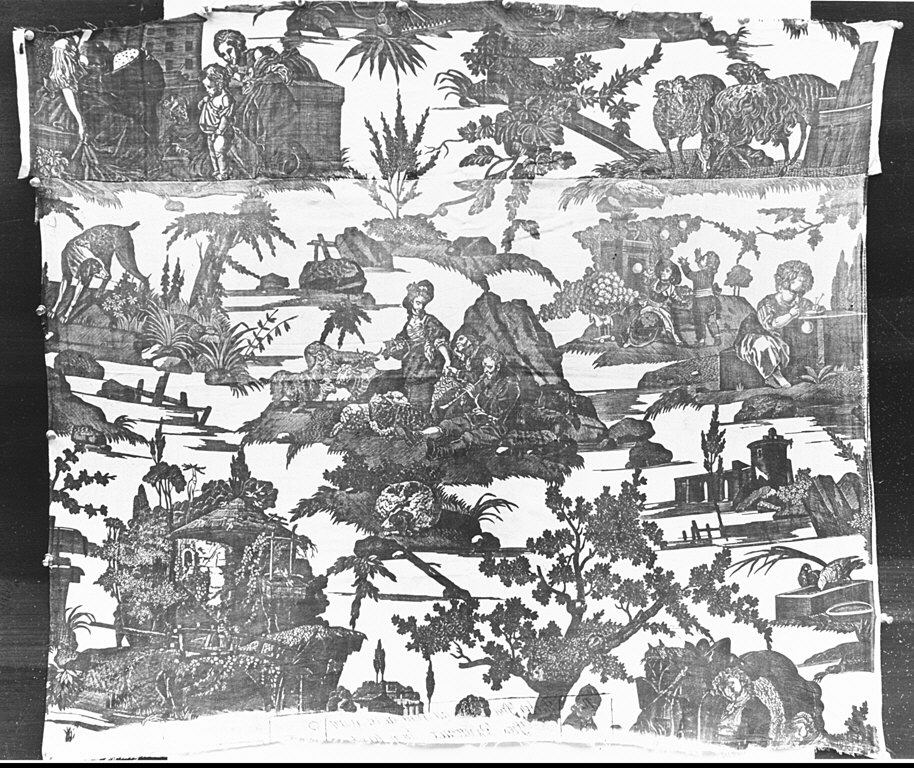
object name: piece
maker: lecler, père et fils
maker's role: manufactory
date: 1770-1800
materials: cotton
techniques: printing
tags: human figures,children,dogs,sheep